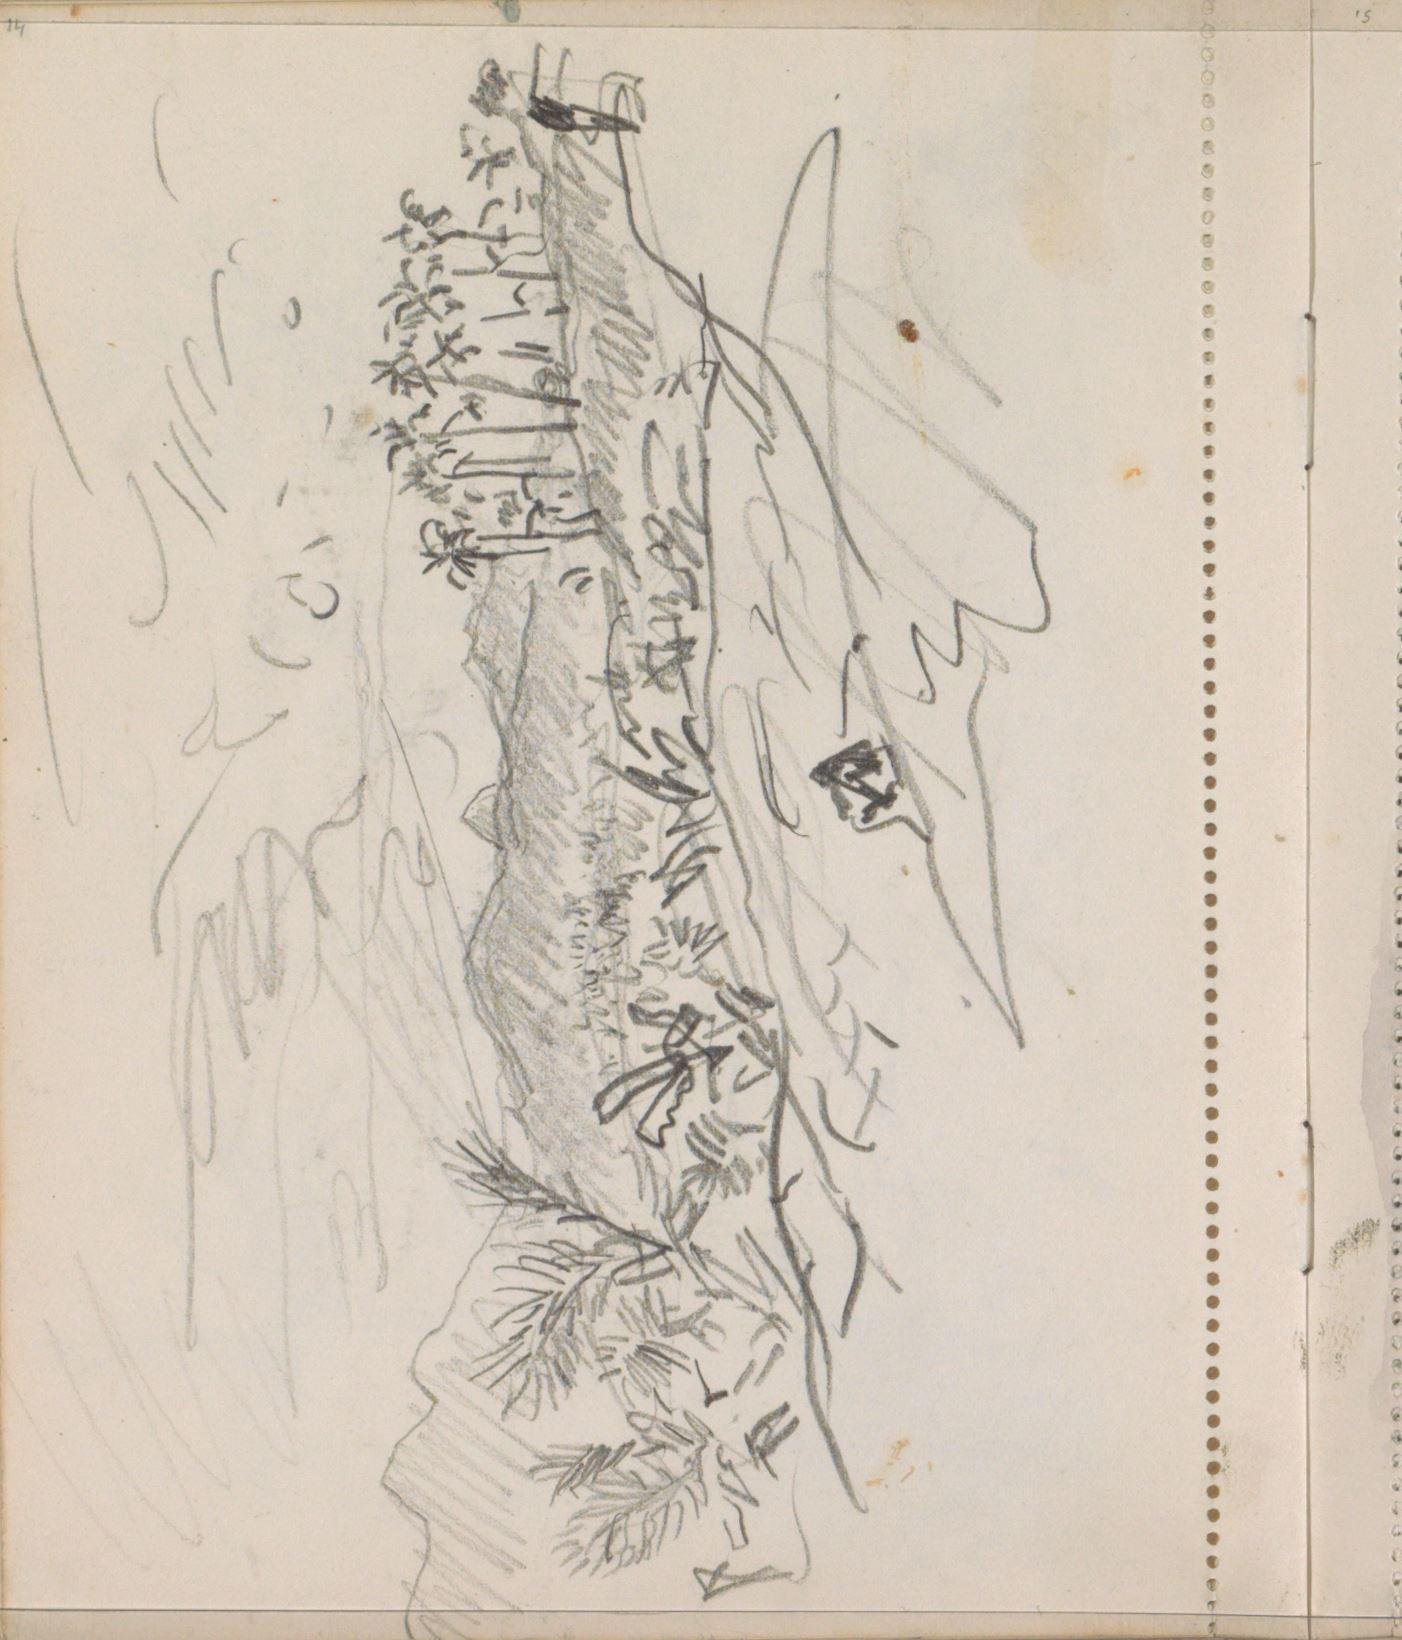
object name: sketchbook leaf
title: Heuvellandschap met sawa's en palmbomen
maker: marius bauer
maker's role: draughtsman, print maker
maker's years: 1867-1932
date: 1925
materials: paper, pencil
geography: java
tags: low hill country, landscapes, trees: palm-tree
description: Pagina 14 uit een schetsboek met 67 bladen.